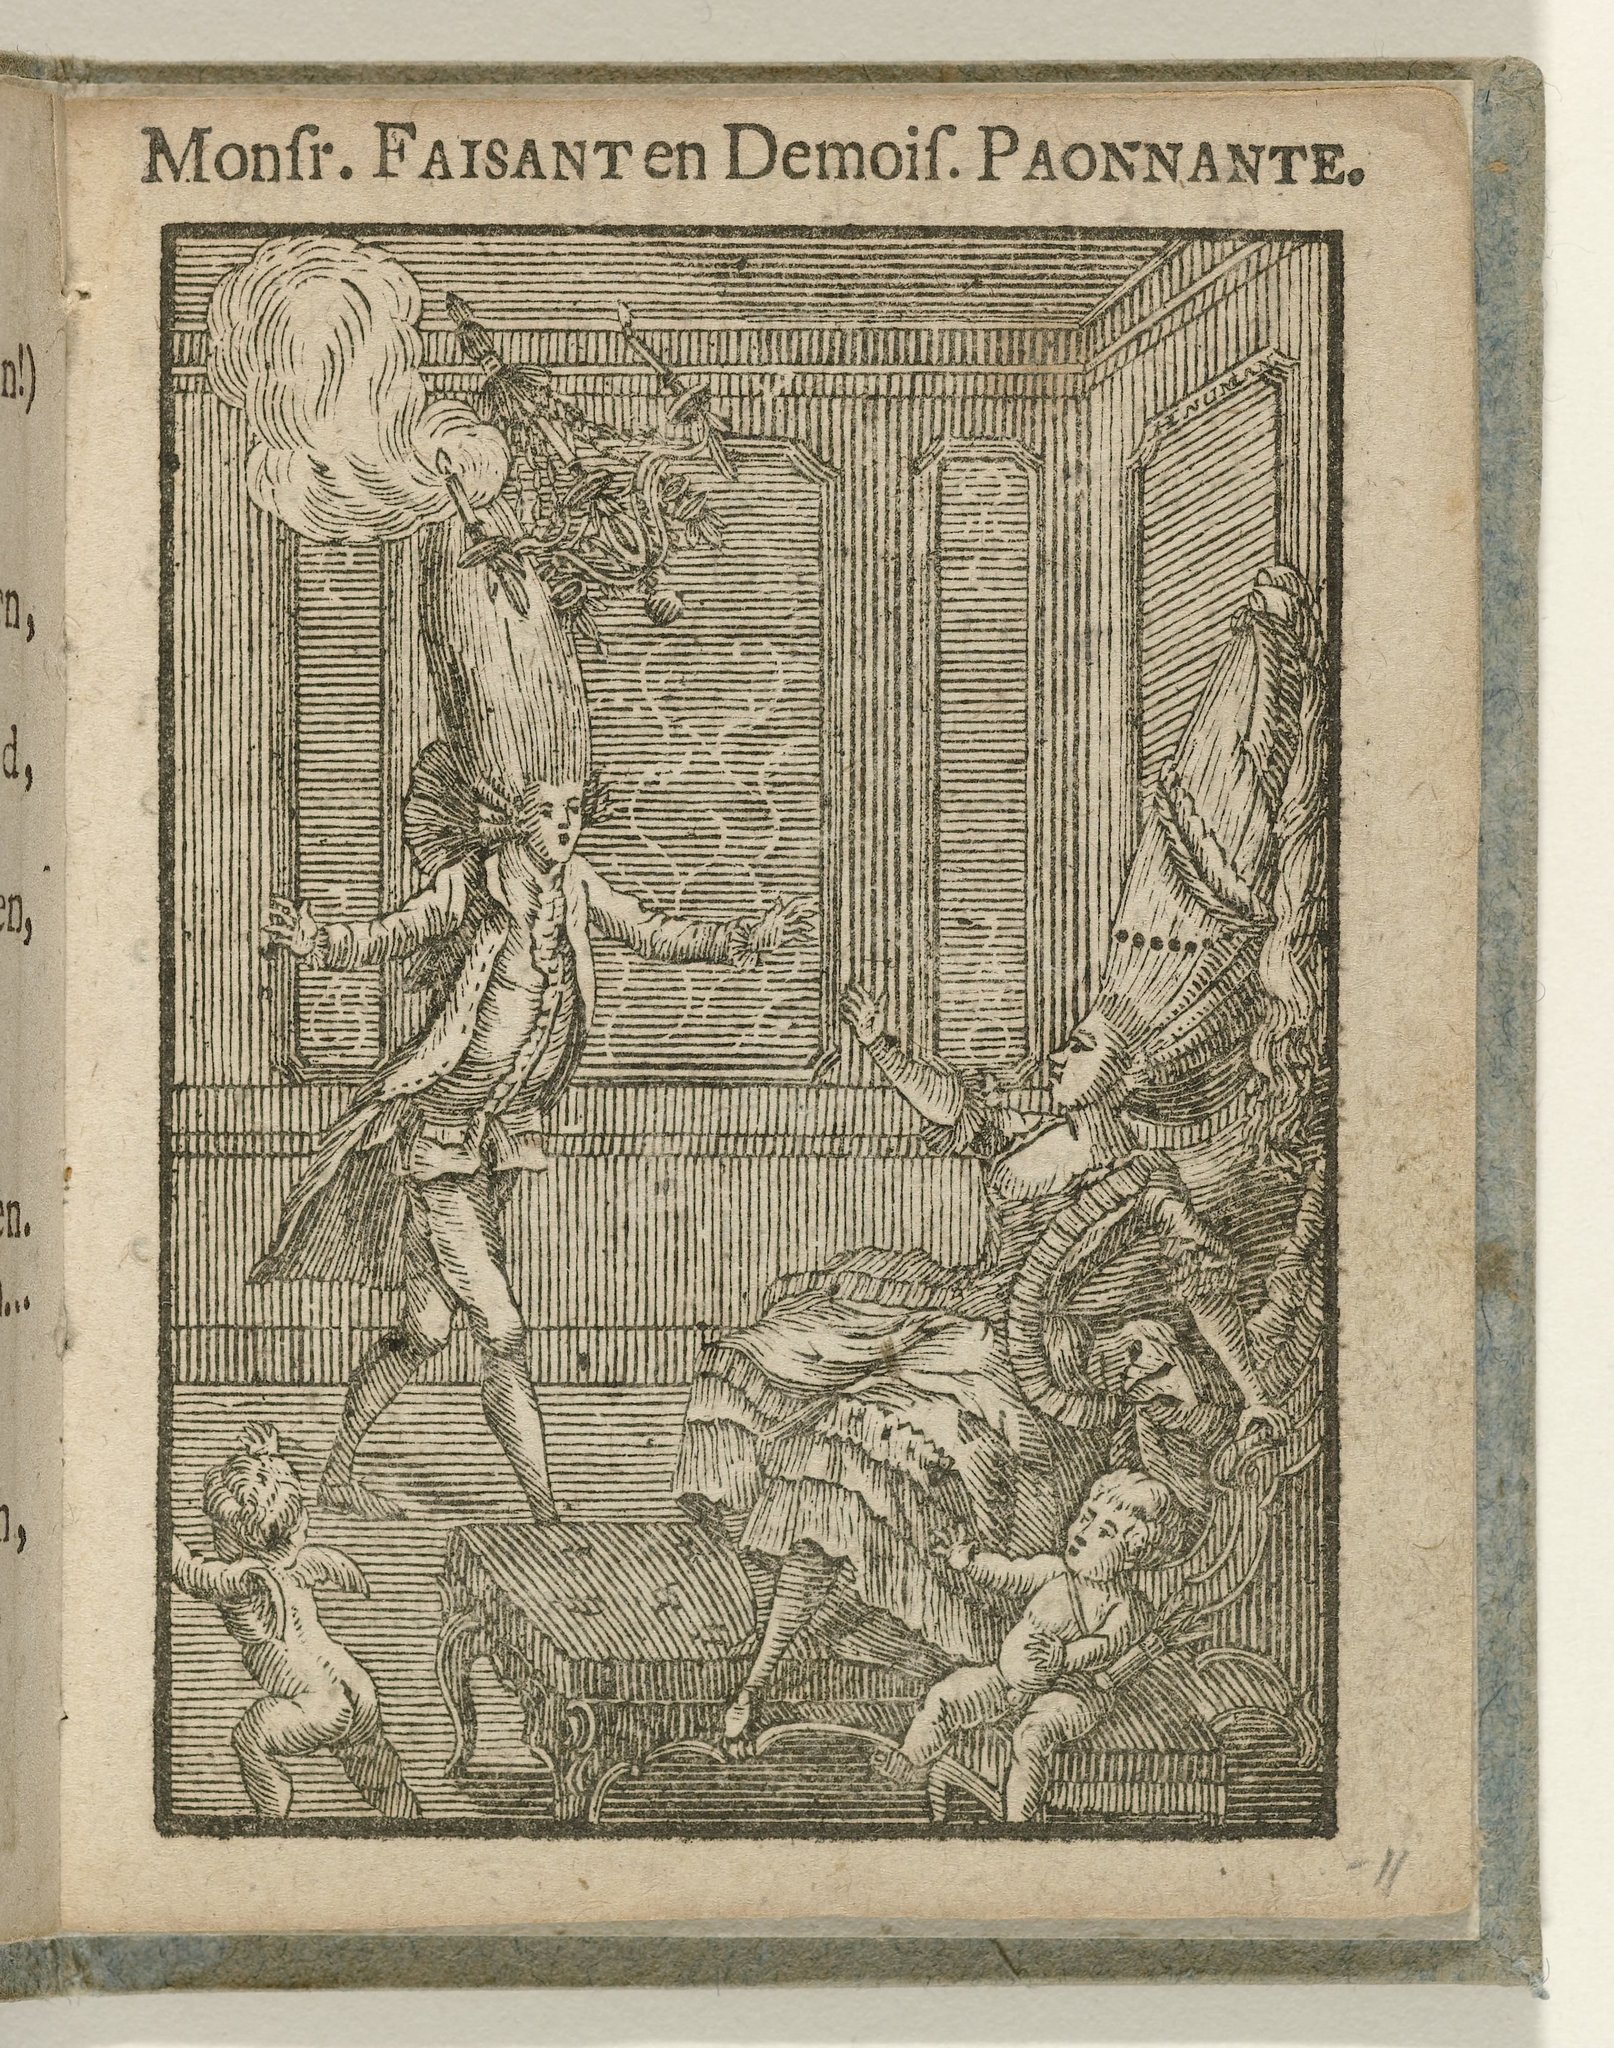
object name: book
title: De zegepraal der Mode..., p. 11: Aanmerking op Monsr. Faisant en Demois. Paonnante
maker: h. numan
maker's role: publisher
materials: paper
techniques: letterpress printing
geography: rotterdam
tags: wig - aa - ~ women, wig, burning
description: P. 11 van boekje waarin de Parijse mode van de overdreven hogekapsels wordt bespot:. De verliefde minnaar let niet op waar hij loopt, zodat zijn hoge kapsel vlam vat in de kroonluchter.